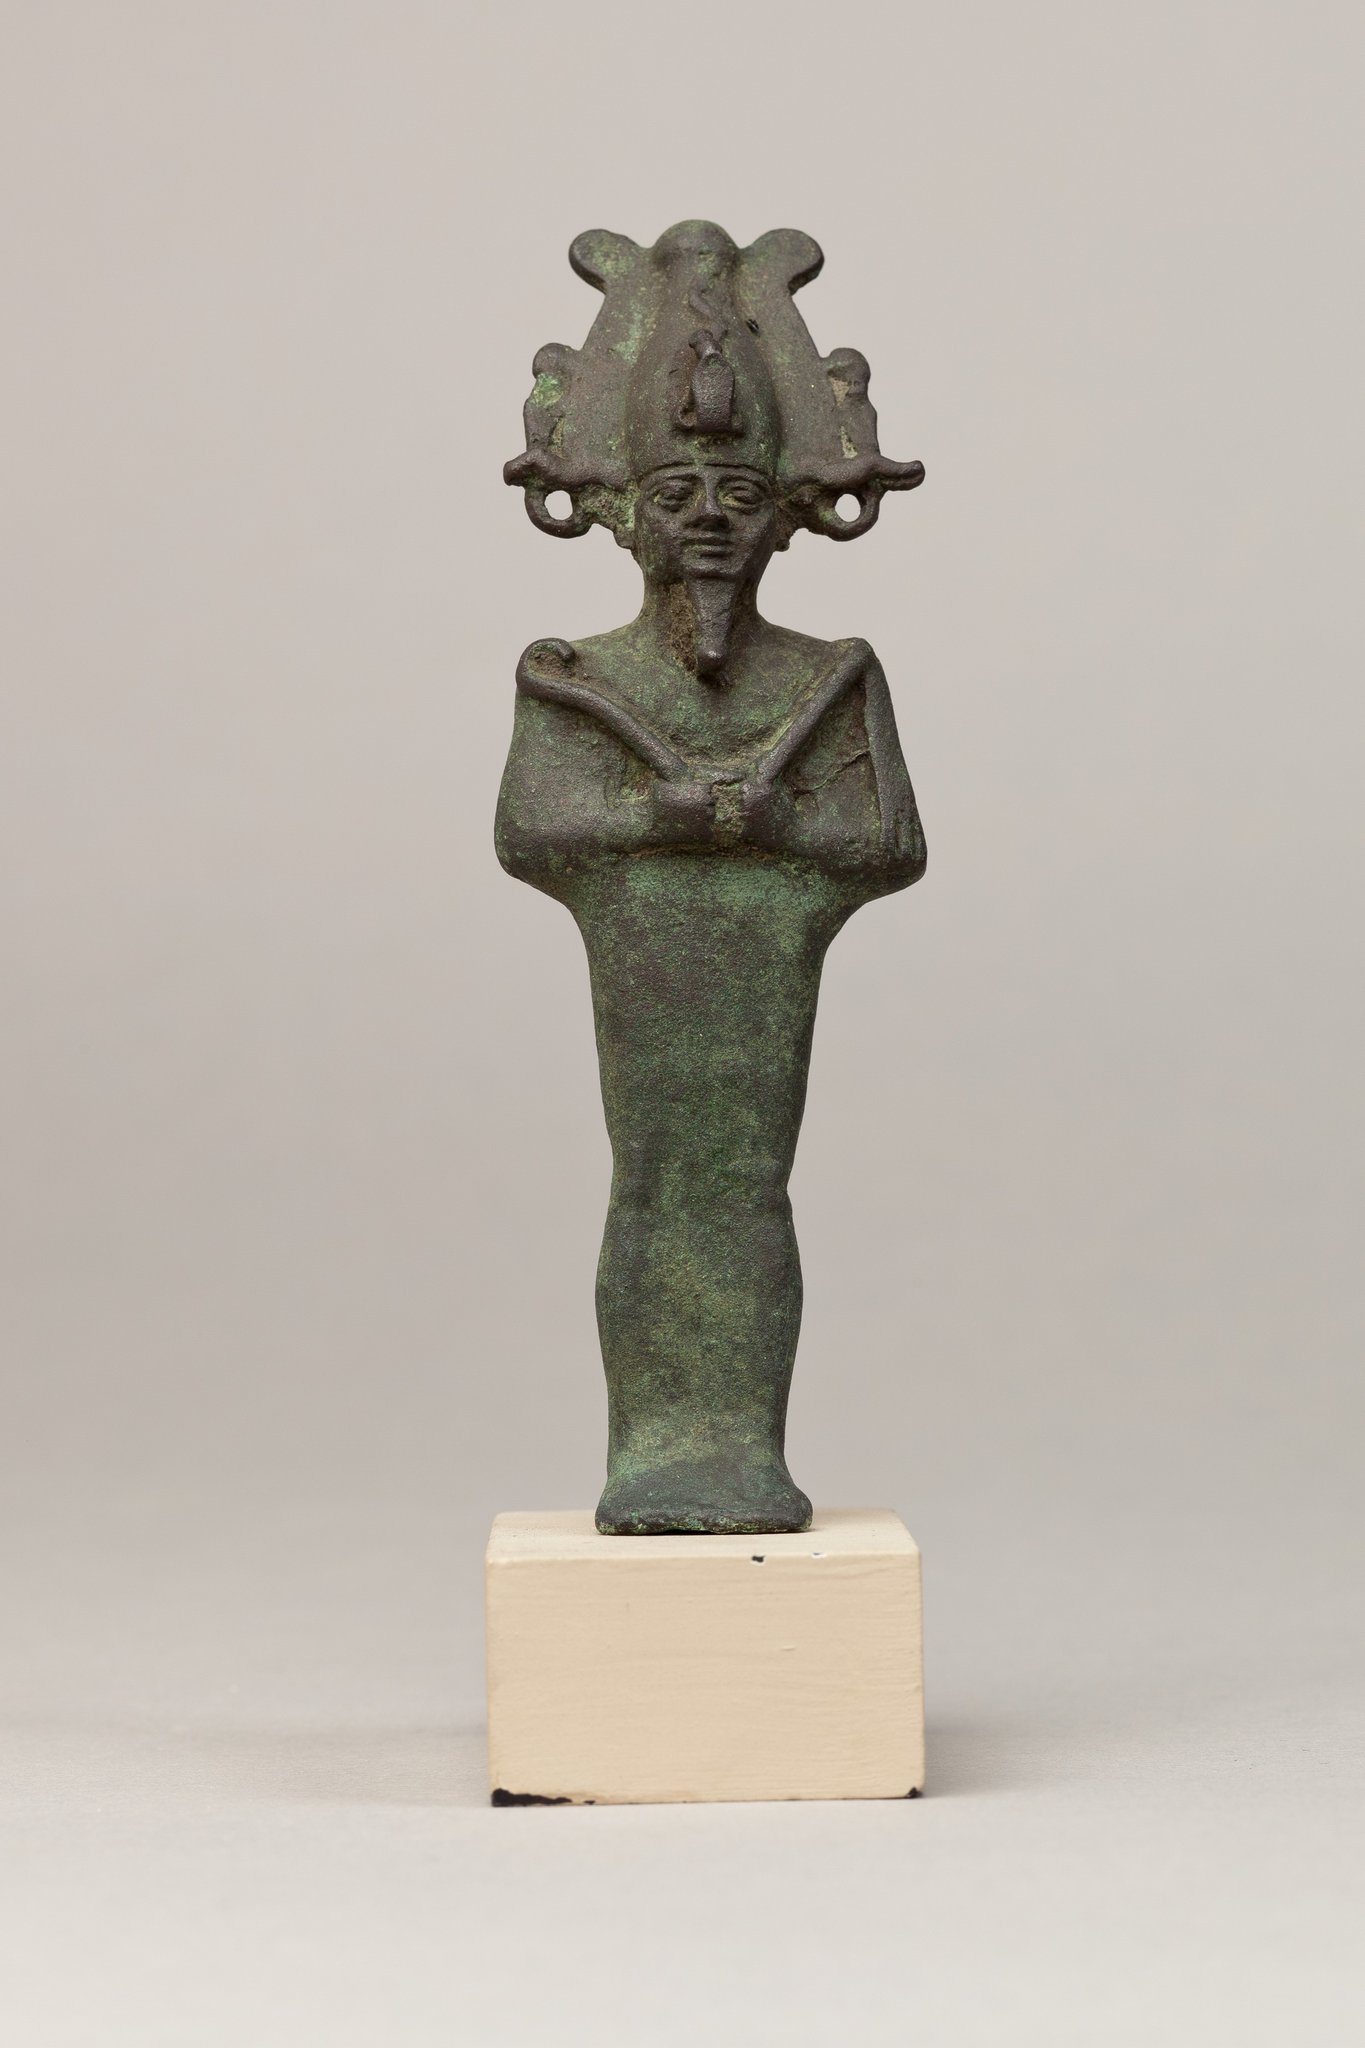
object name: statuette, osiris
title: Osiris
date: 664-630 BCE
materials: metal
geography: egypt